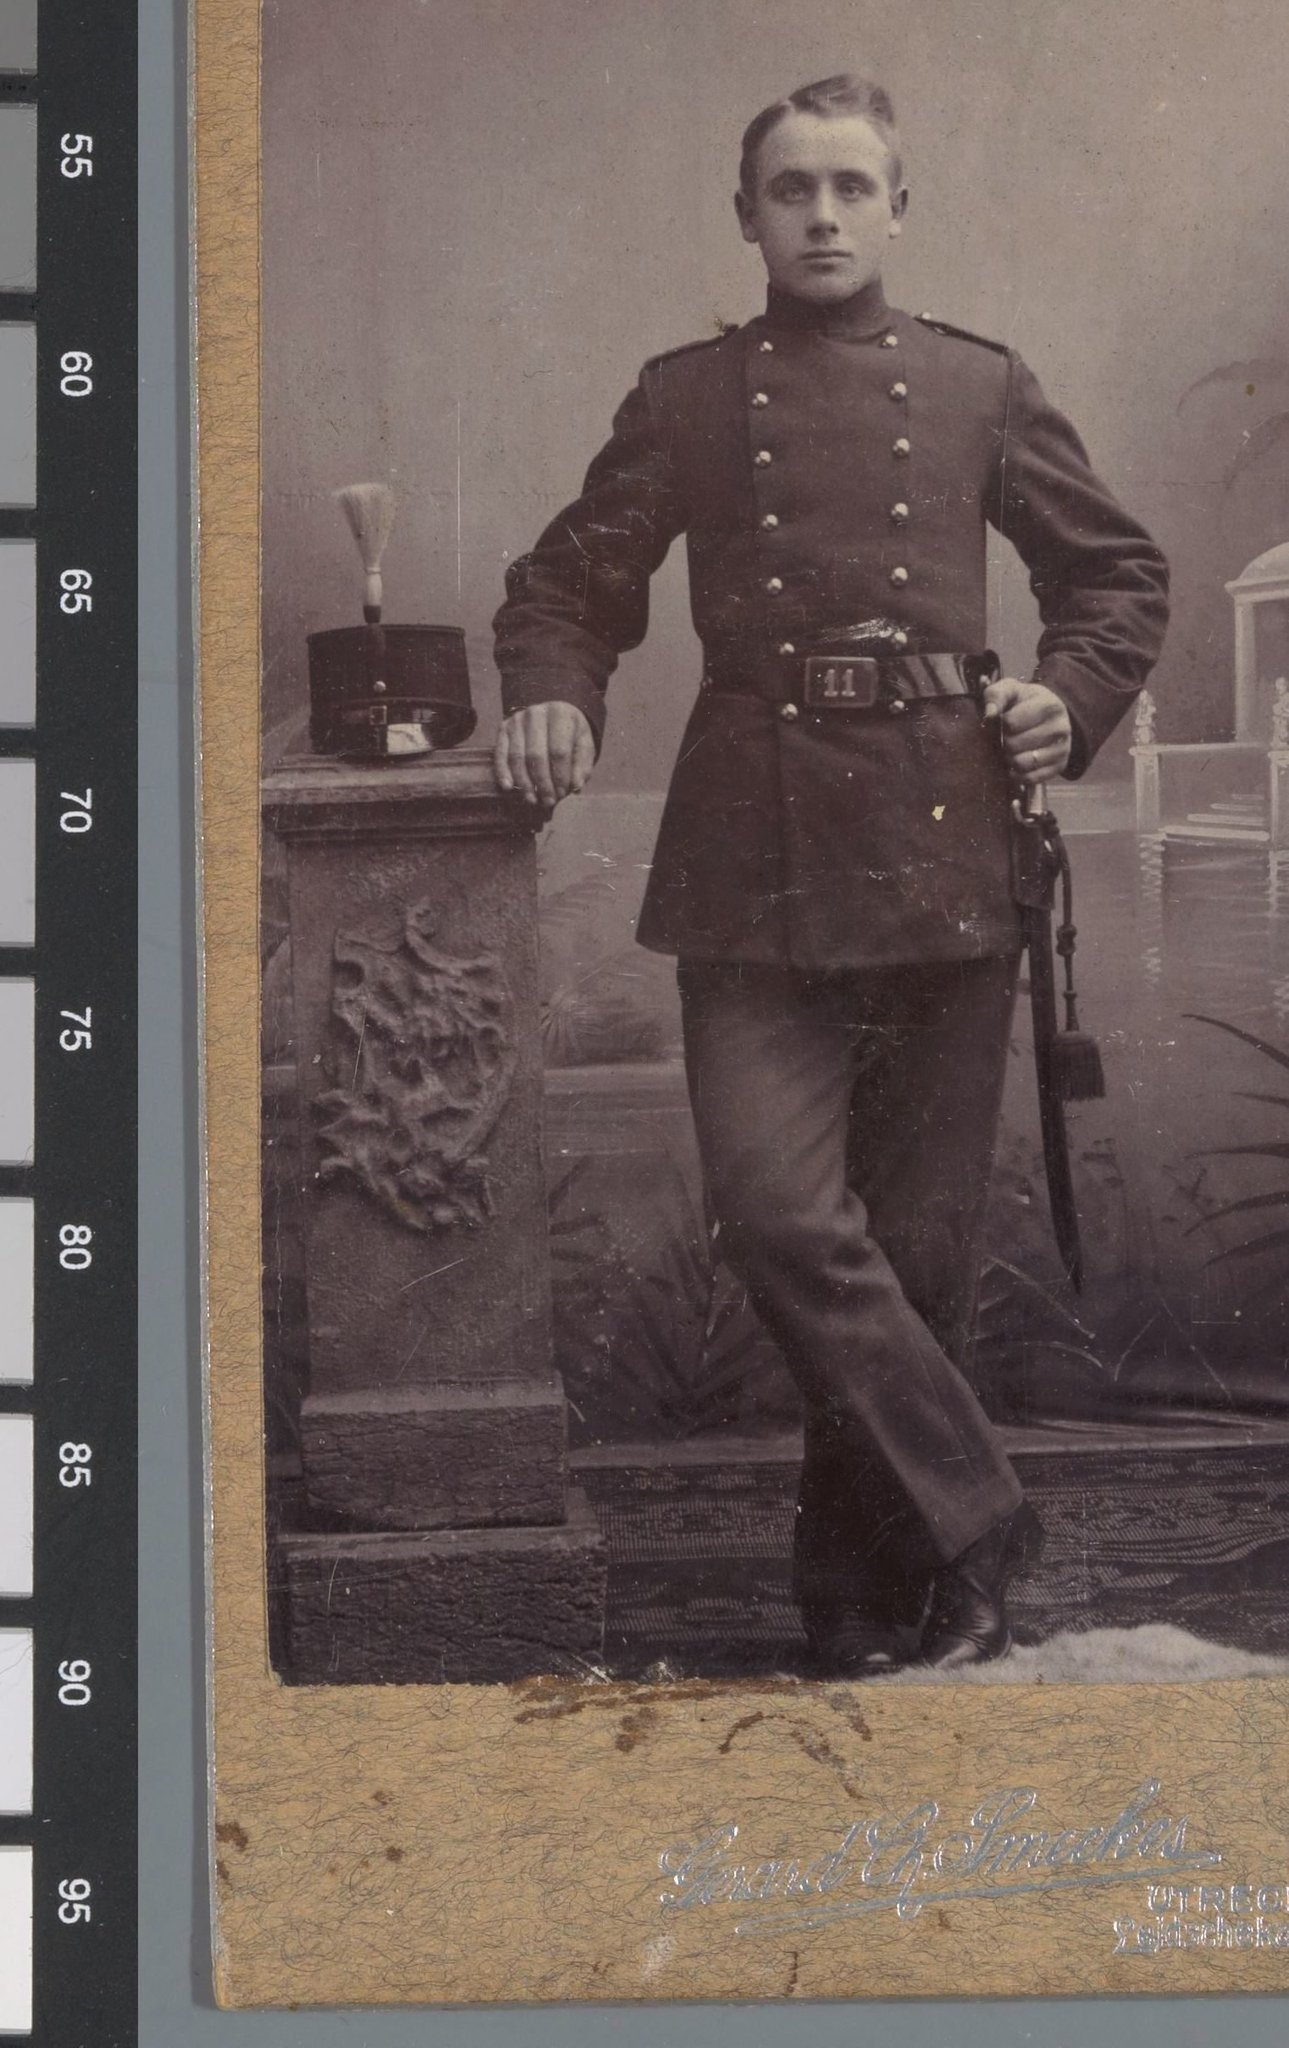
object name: carte de visite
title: Portret van een onbekende jongeman in uniform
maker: gerardus christiaan smeekes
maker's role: fotograaf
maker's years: 1875-1948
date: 1901-1908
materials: paper, cardboard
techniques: gelatin silver print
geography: utrecht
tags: youth, adolescent, anonymous historical person portrayed, (military) uniforms, utrecht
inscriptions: monogram: ‘GCh.S’, inscription: ‘Gerard Ch. Smeekes/ Fotograaf/ Utrecht/ Leidschekade 19/ Telefoon 1418./ Vergrootingen naar oude en verbleekte portretten./ Specialiteit in buitenopnamen./ Men lette vooral op het huisnummer./ Prager & Lojda, Berlin/ 25.8.05.’, inscription: ‘Gerard Ch. Smeekes/ Utrecht/ Leidschekade 19’